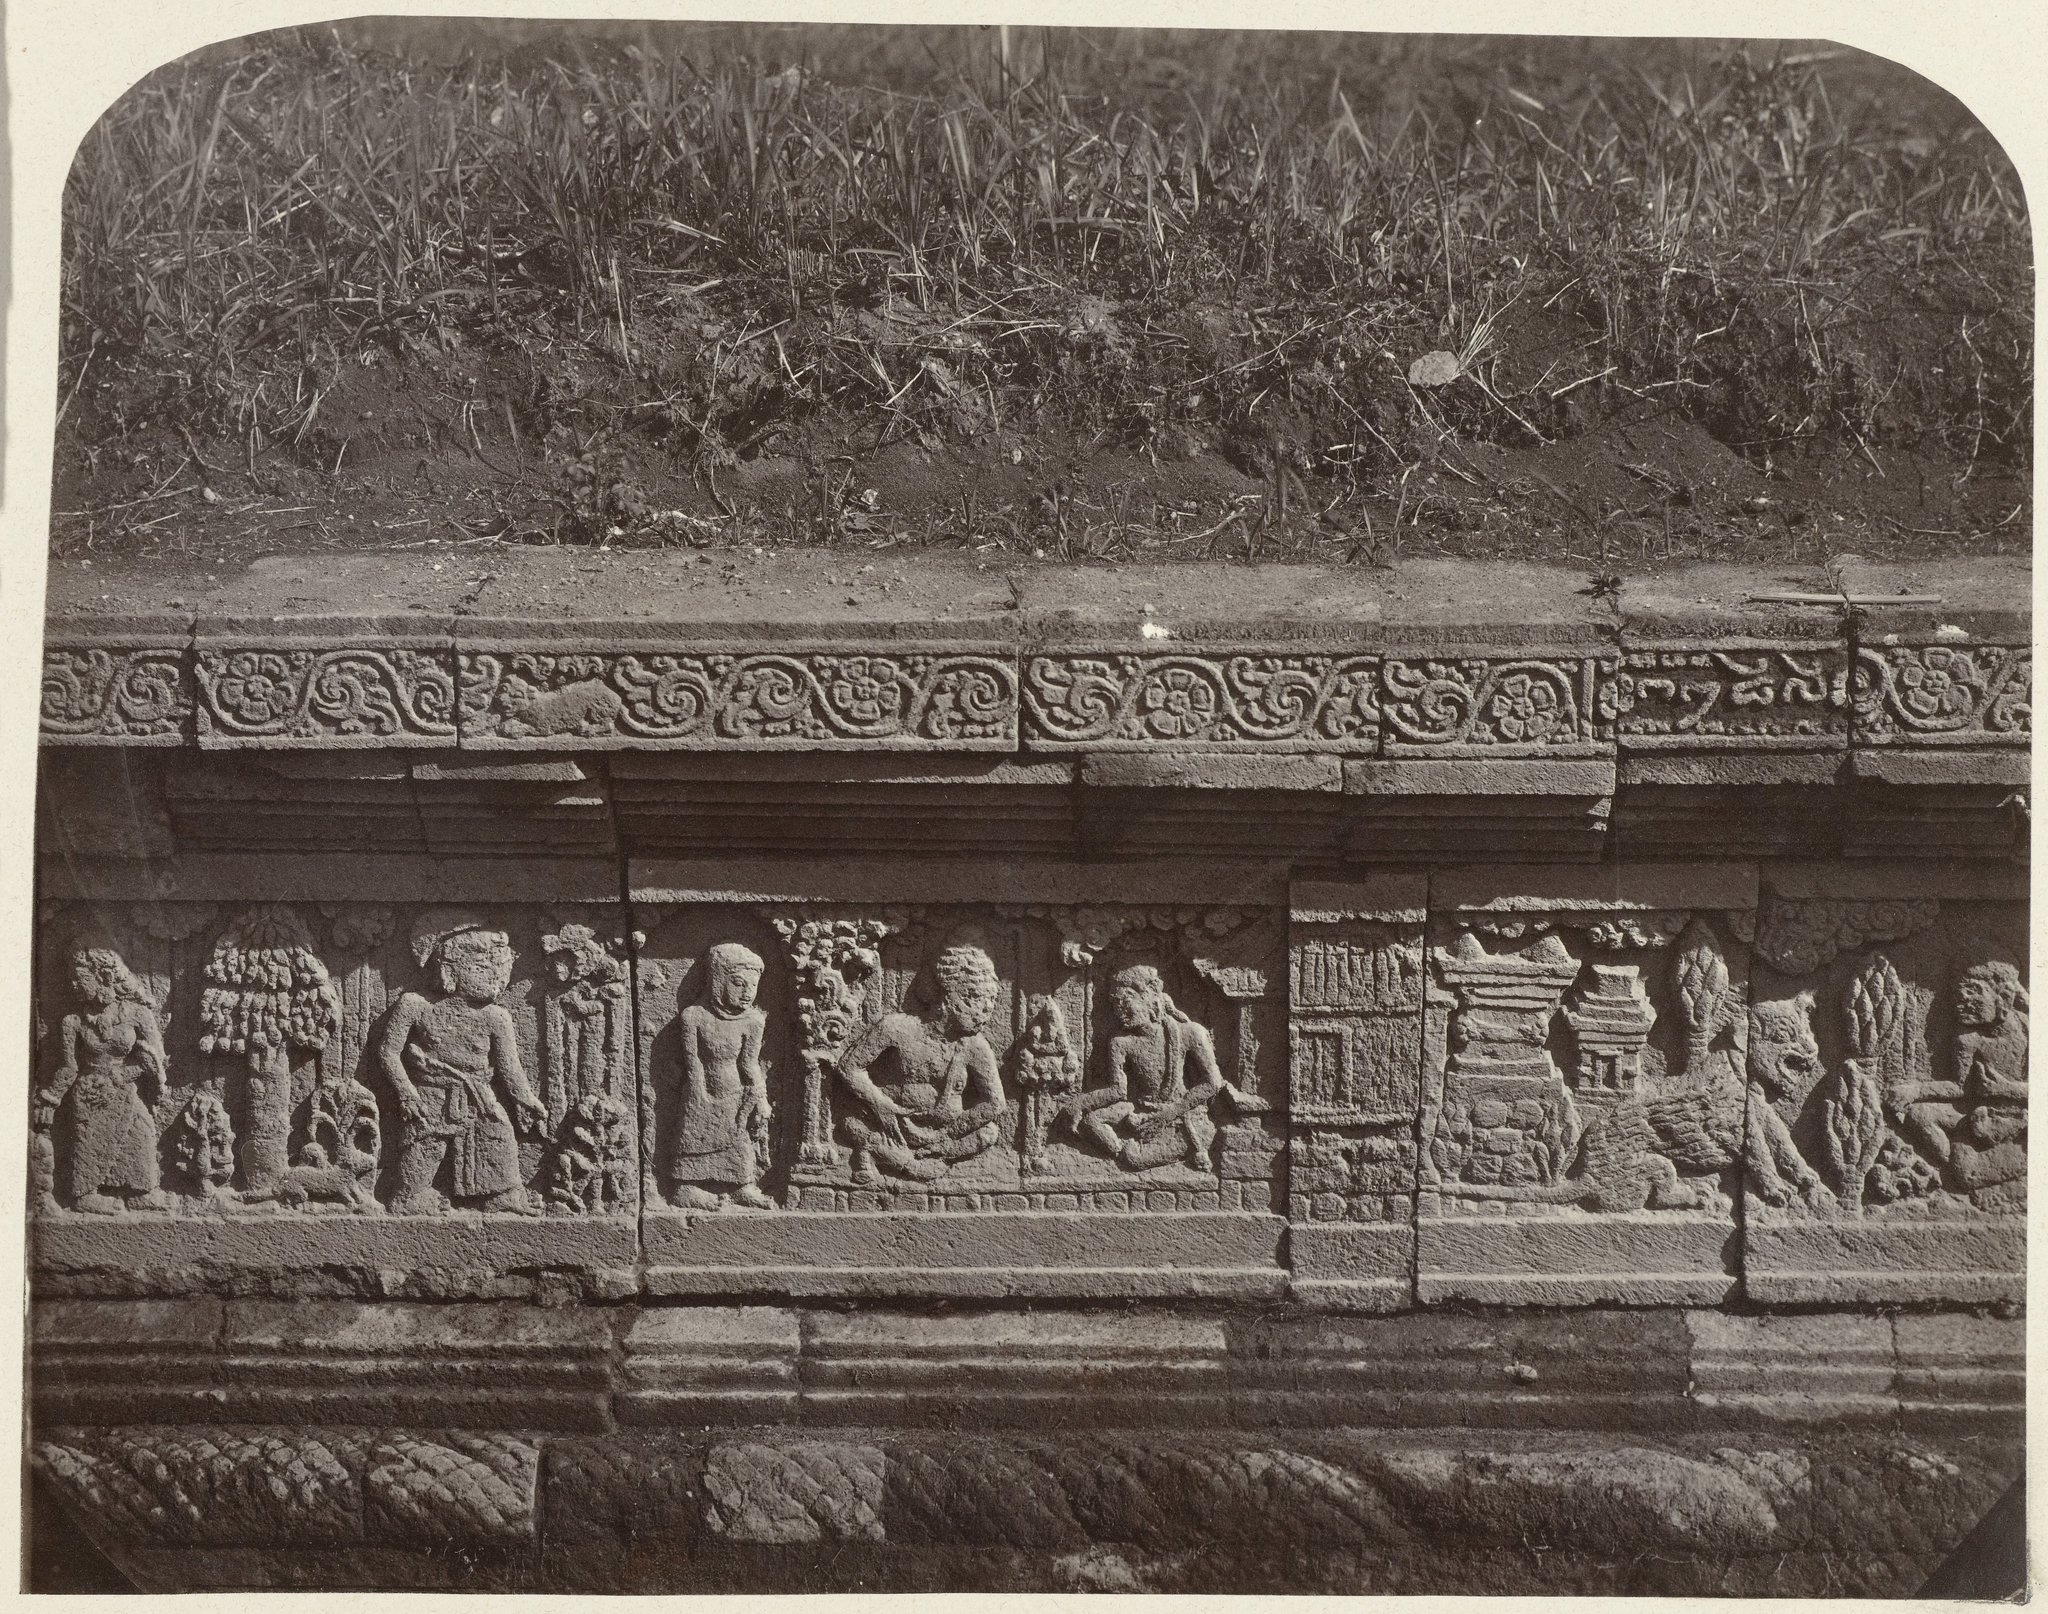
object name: photograph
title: Basreliëf op het voetstuk van een pendopo, afgesloten door een Naga aan de oostzijde van Candi Panataran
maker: isidore kinsbergen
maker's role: fotograaf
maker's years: 1821-1905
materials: cardboard, paper, photographic support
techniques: albumen print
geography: java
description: Candi Panataran (Temple Complex), Pendopo terrace, reliefs 17-20 (end of the 'Sang Satyawan' story and opening scenes of the 'Bubaksha and Gagang Aking' story), east side. Panataran, Blitar district, East Java province 1375 AD.